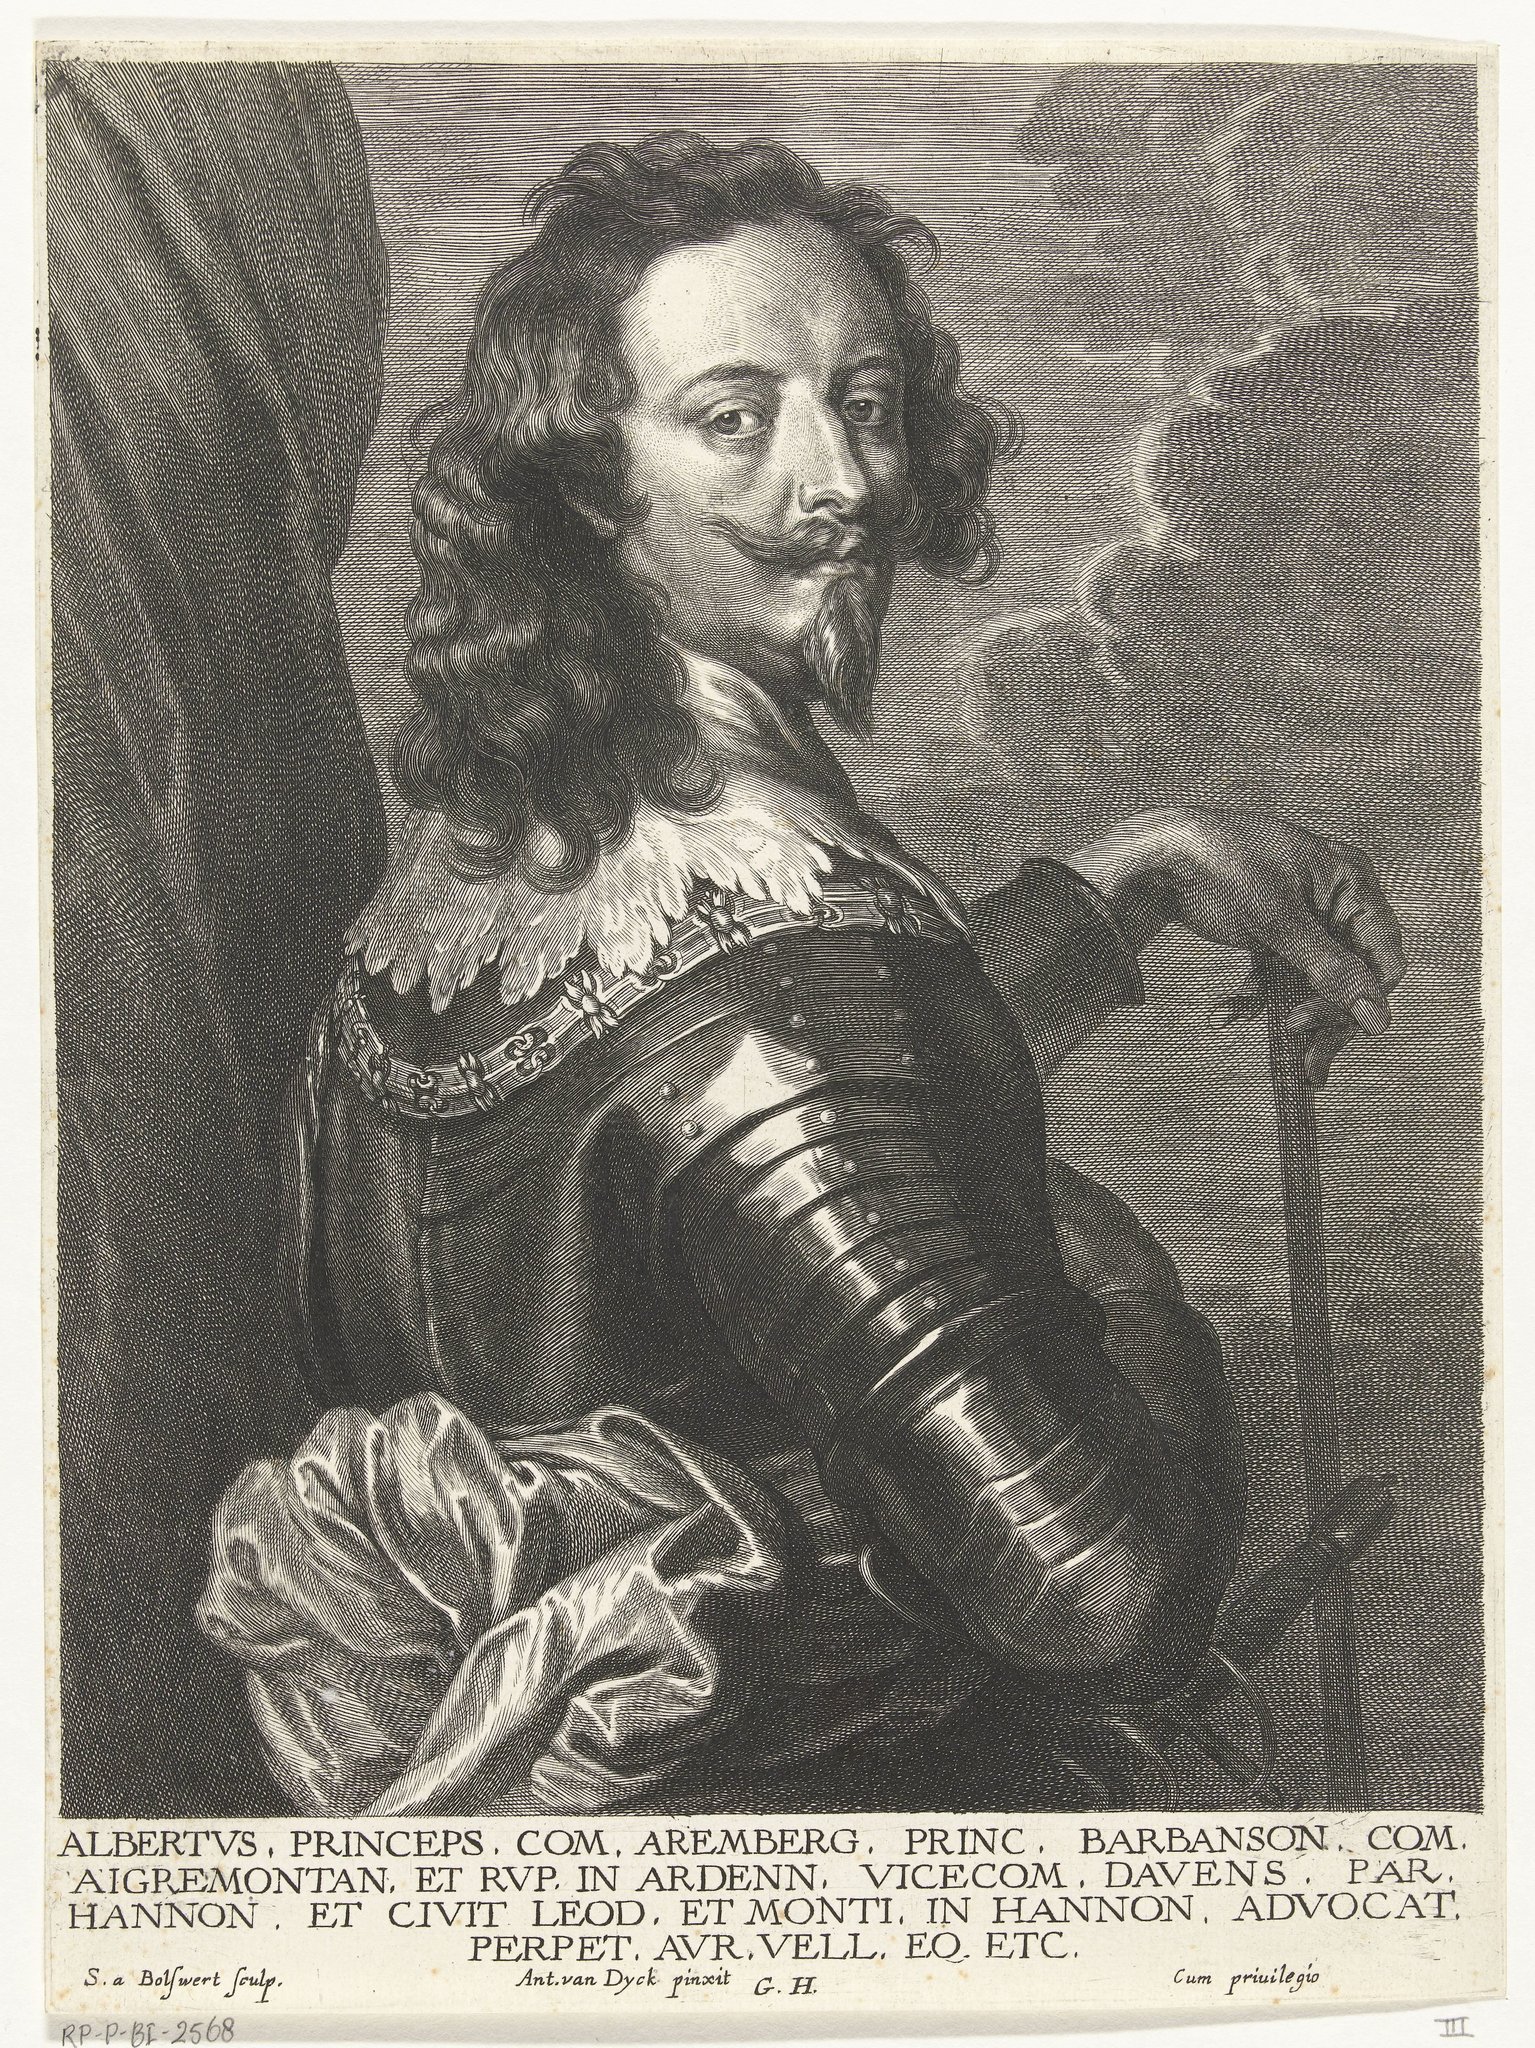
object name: print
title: Portret van Albert, graaf van Arenberg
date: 1627-1659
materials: paper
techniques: engraving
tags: albert de ligne (prins van barbançon en arenberg)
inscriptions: collector's mark: Lugt 240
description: Prent naar schilderij van Anthony van Dyck dat zich bevindt in Holkham Hall, Norfolk. Het portret moet van na 1627 dateren want in dat jaar werd de graaf ridder in de Orde van het Gulden Vlies, over zijn harnas draagt hij het keten van de orde.